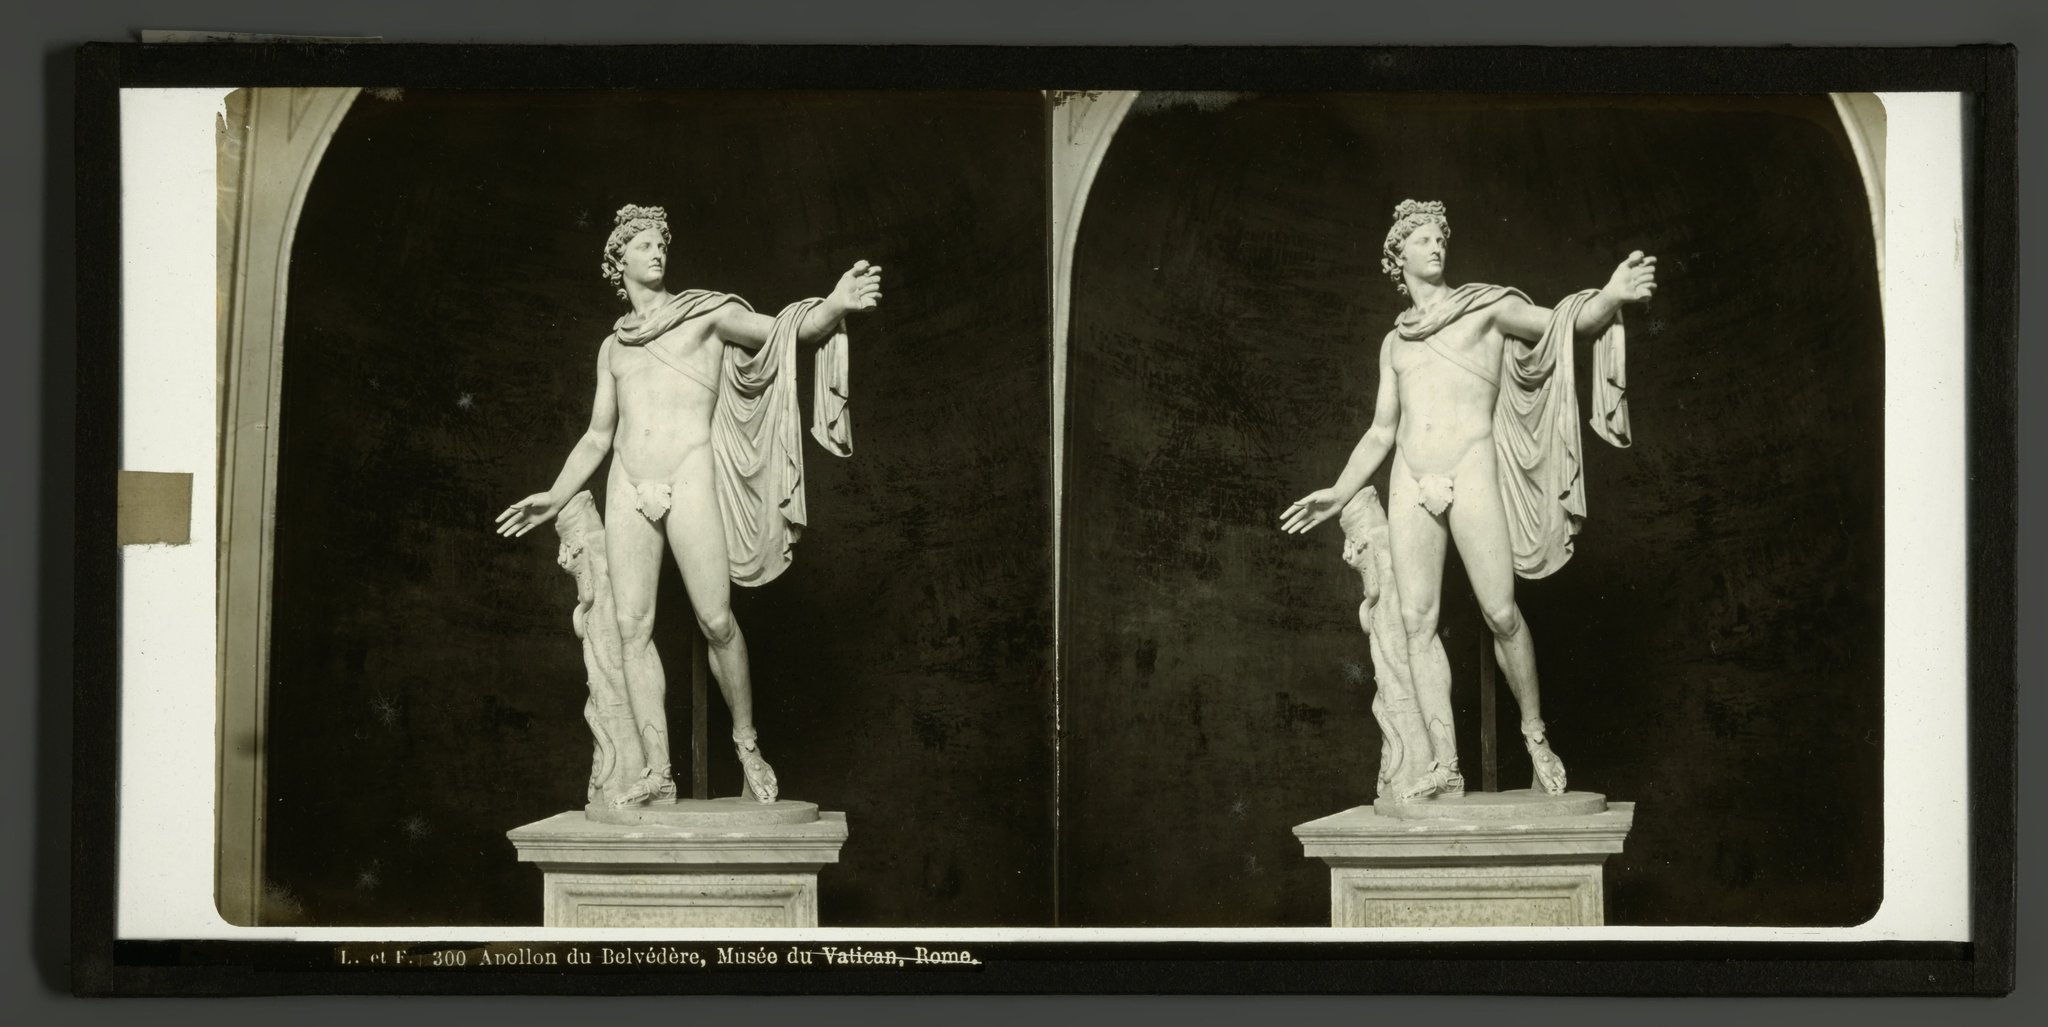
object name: stereoscopic photograph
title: Standbeeld Apollo van Belvedère te Vaticaanstad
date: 1856-1890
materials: glass, paper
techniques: slide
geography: vatican city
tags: (story of) apollo (phoebus), sculpture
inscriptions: inscription: ‘L. et F. 300 Apollon du Belvédère, Musee du Vatican, Rome’